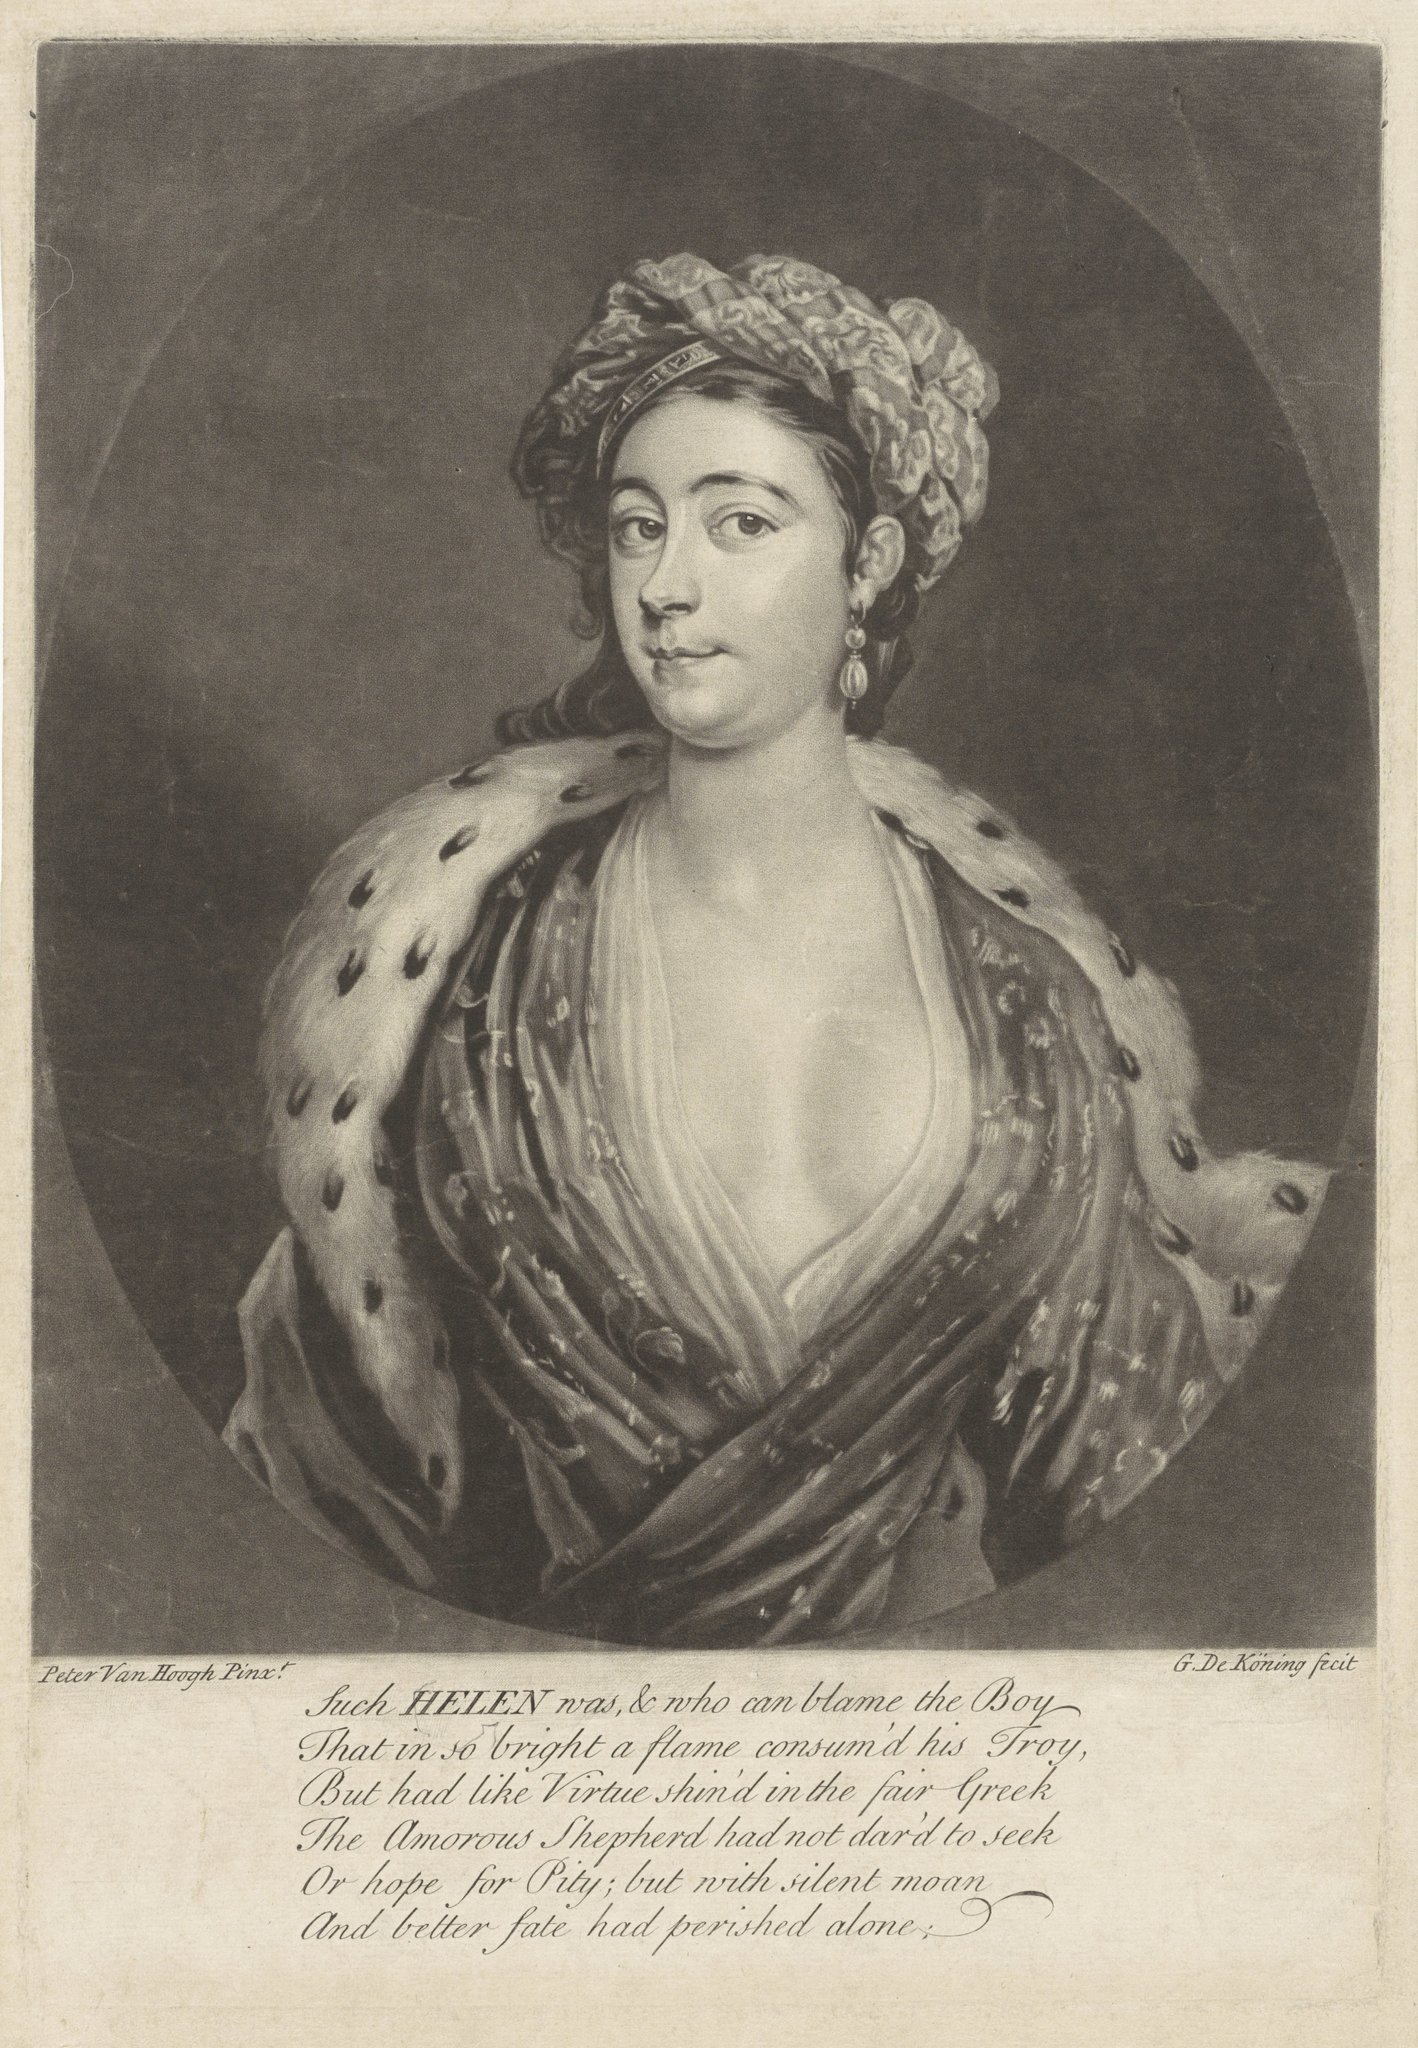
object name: print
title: Portret Amelia Sophia de Walmoden gravin van Yarmouth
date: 1739-1765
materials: paper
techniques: engraving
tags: necklace (+ women's clothes)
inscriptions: collector's mark: Lugt 2228